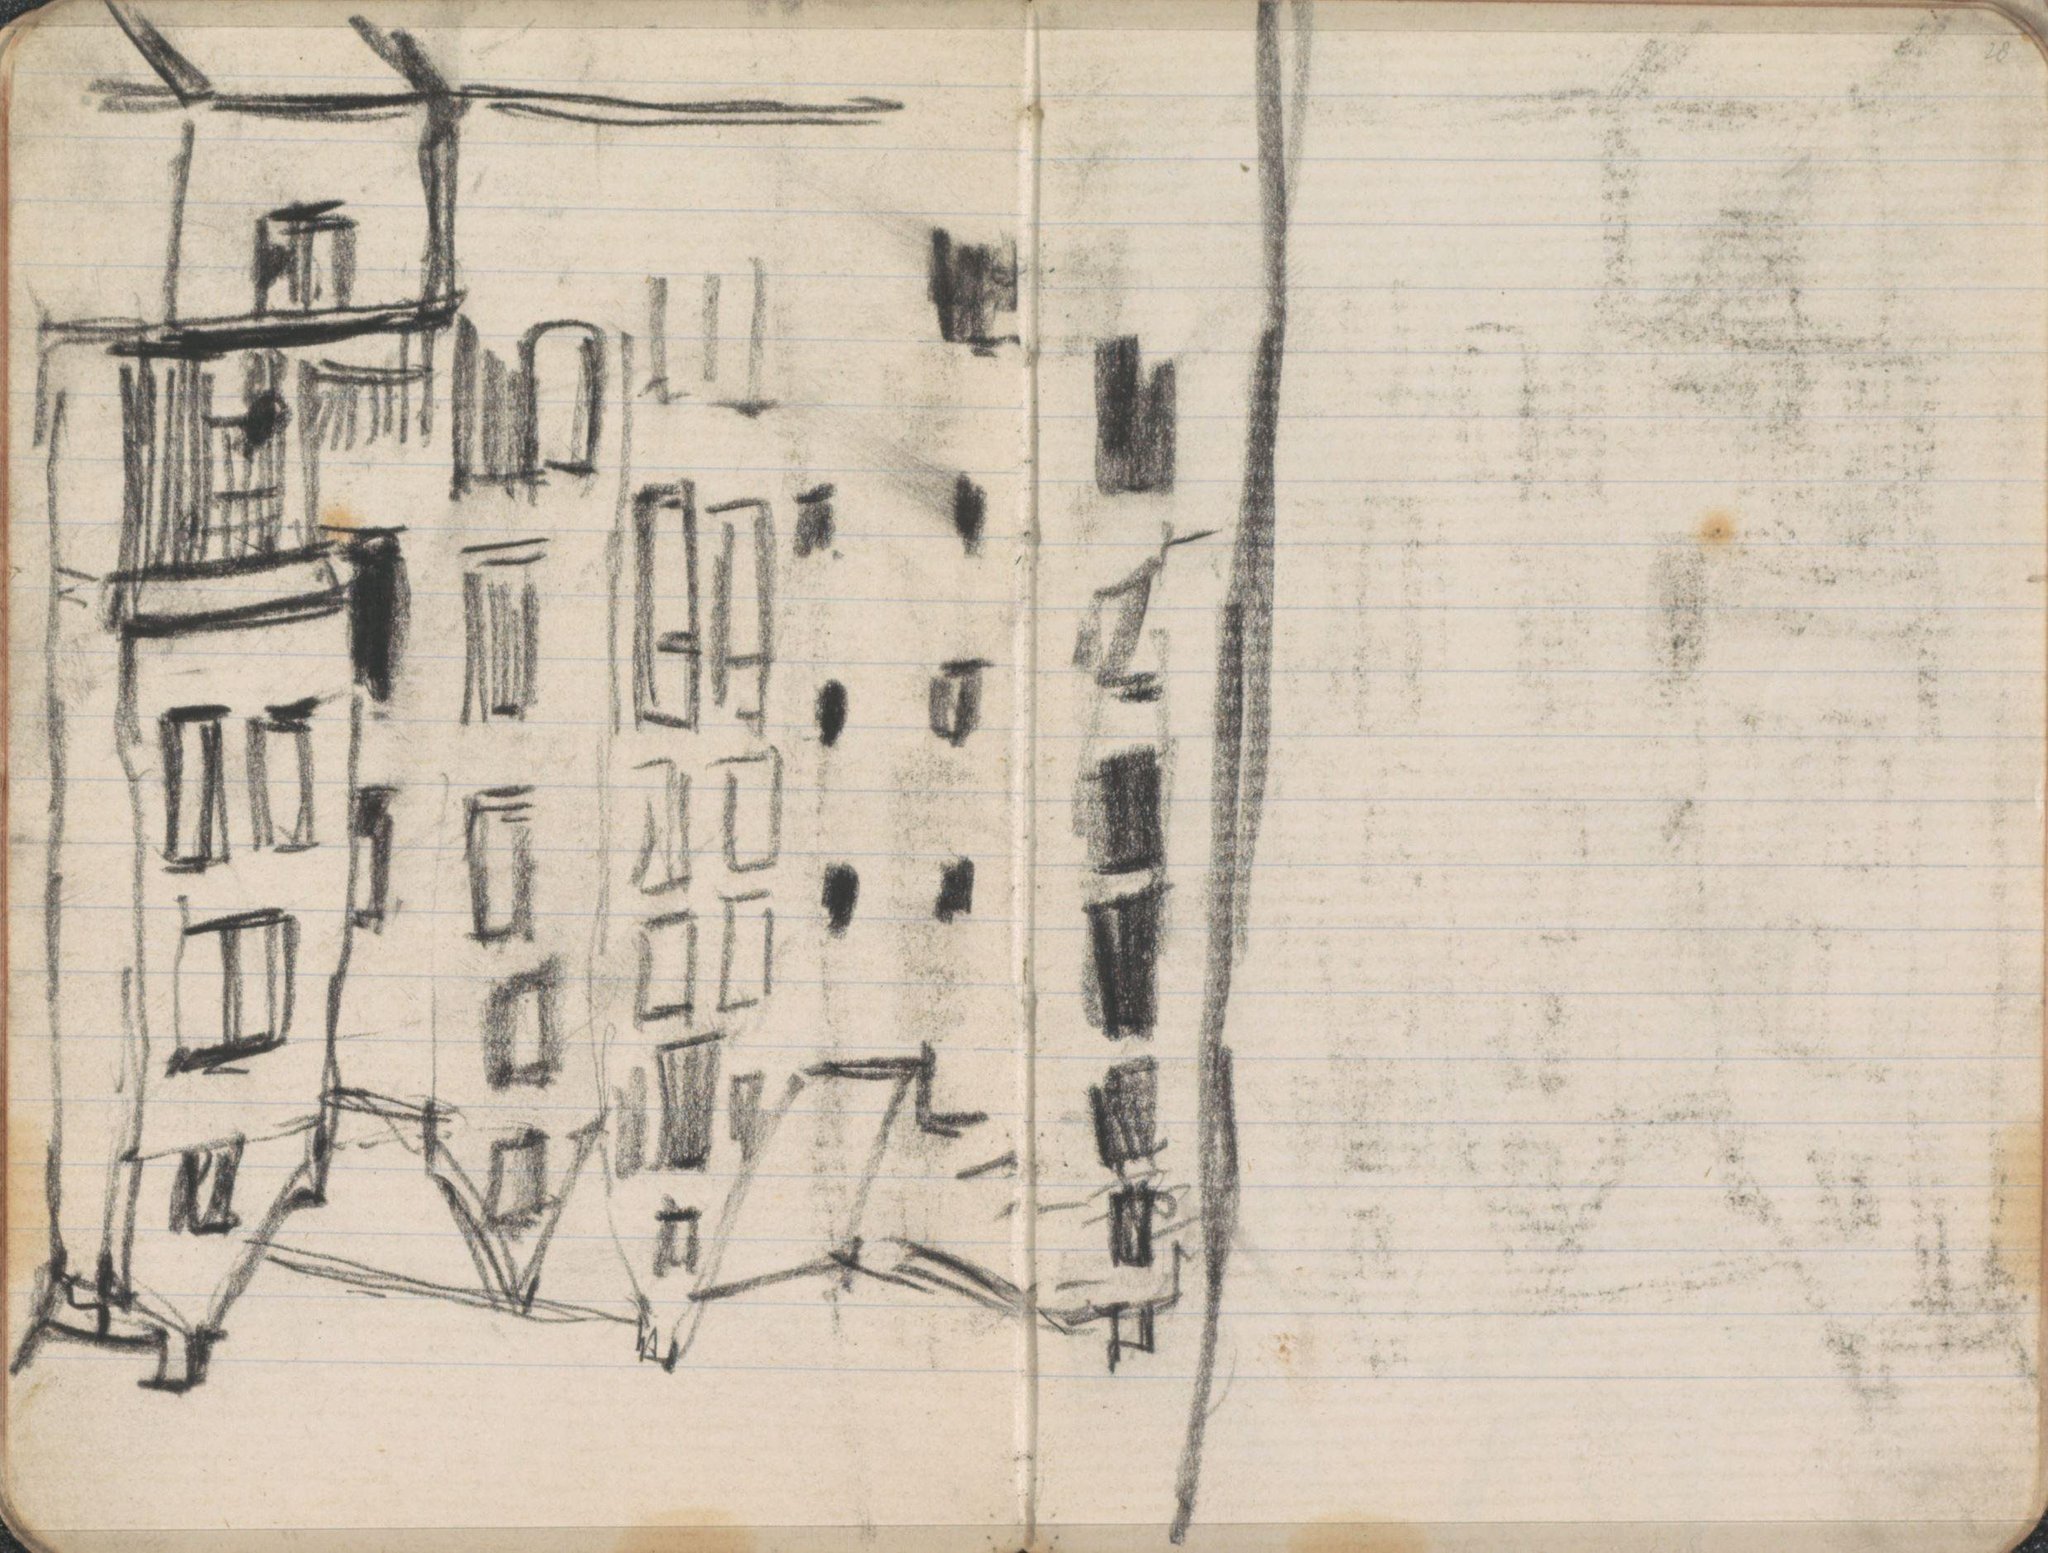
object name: sketchbook leaf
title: Gezicht op huizen aan de Oudezijds Kolk te Amsterdam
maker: george hendrik breitner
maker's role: draughtsman, painter, print maker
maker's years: 1857-1923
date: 1896-1901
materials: chalk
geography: amsterdam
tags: urban housing, canals, waters (in city)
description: Pagina 27 en pagina 28 uit een schetsboek met 37 bladen.